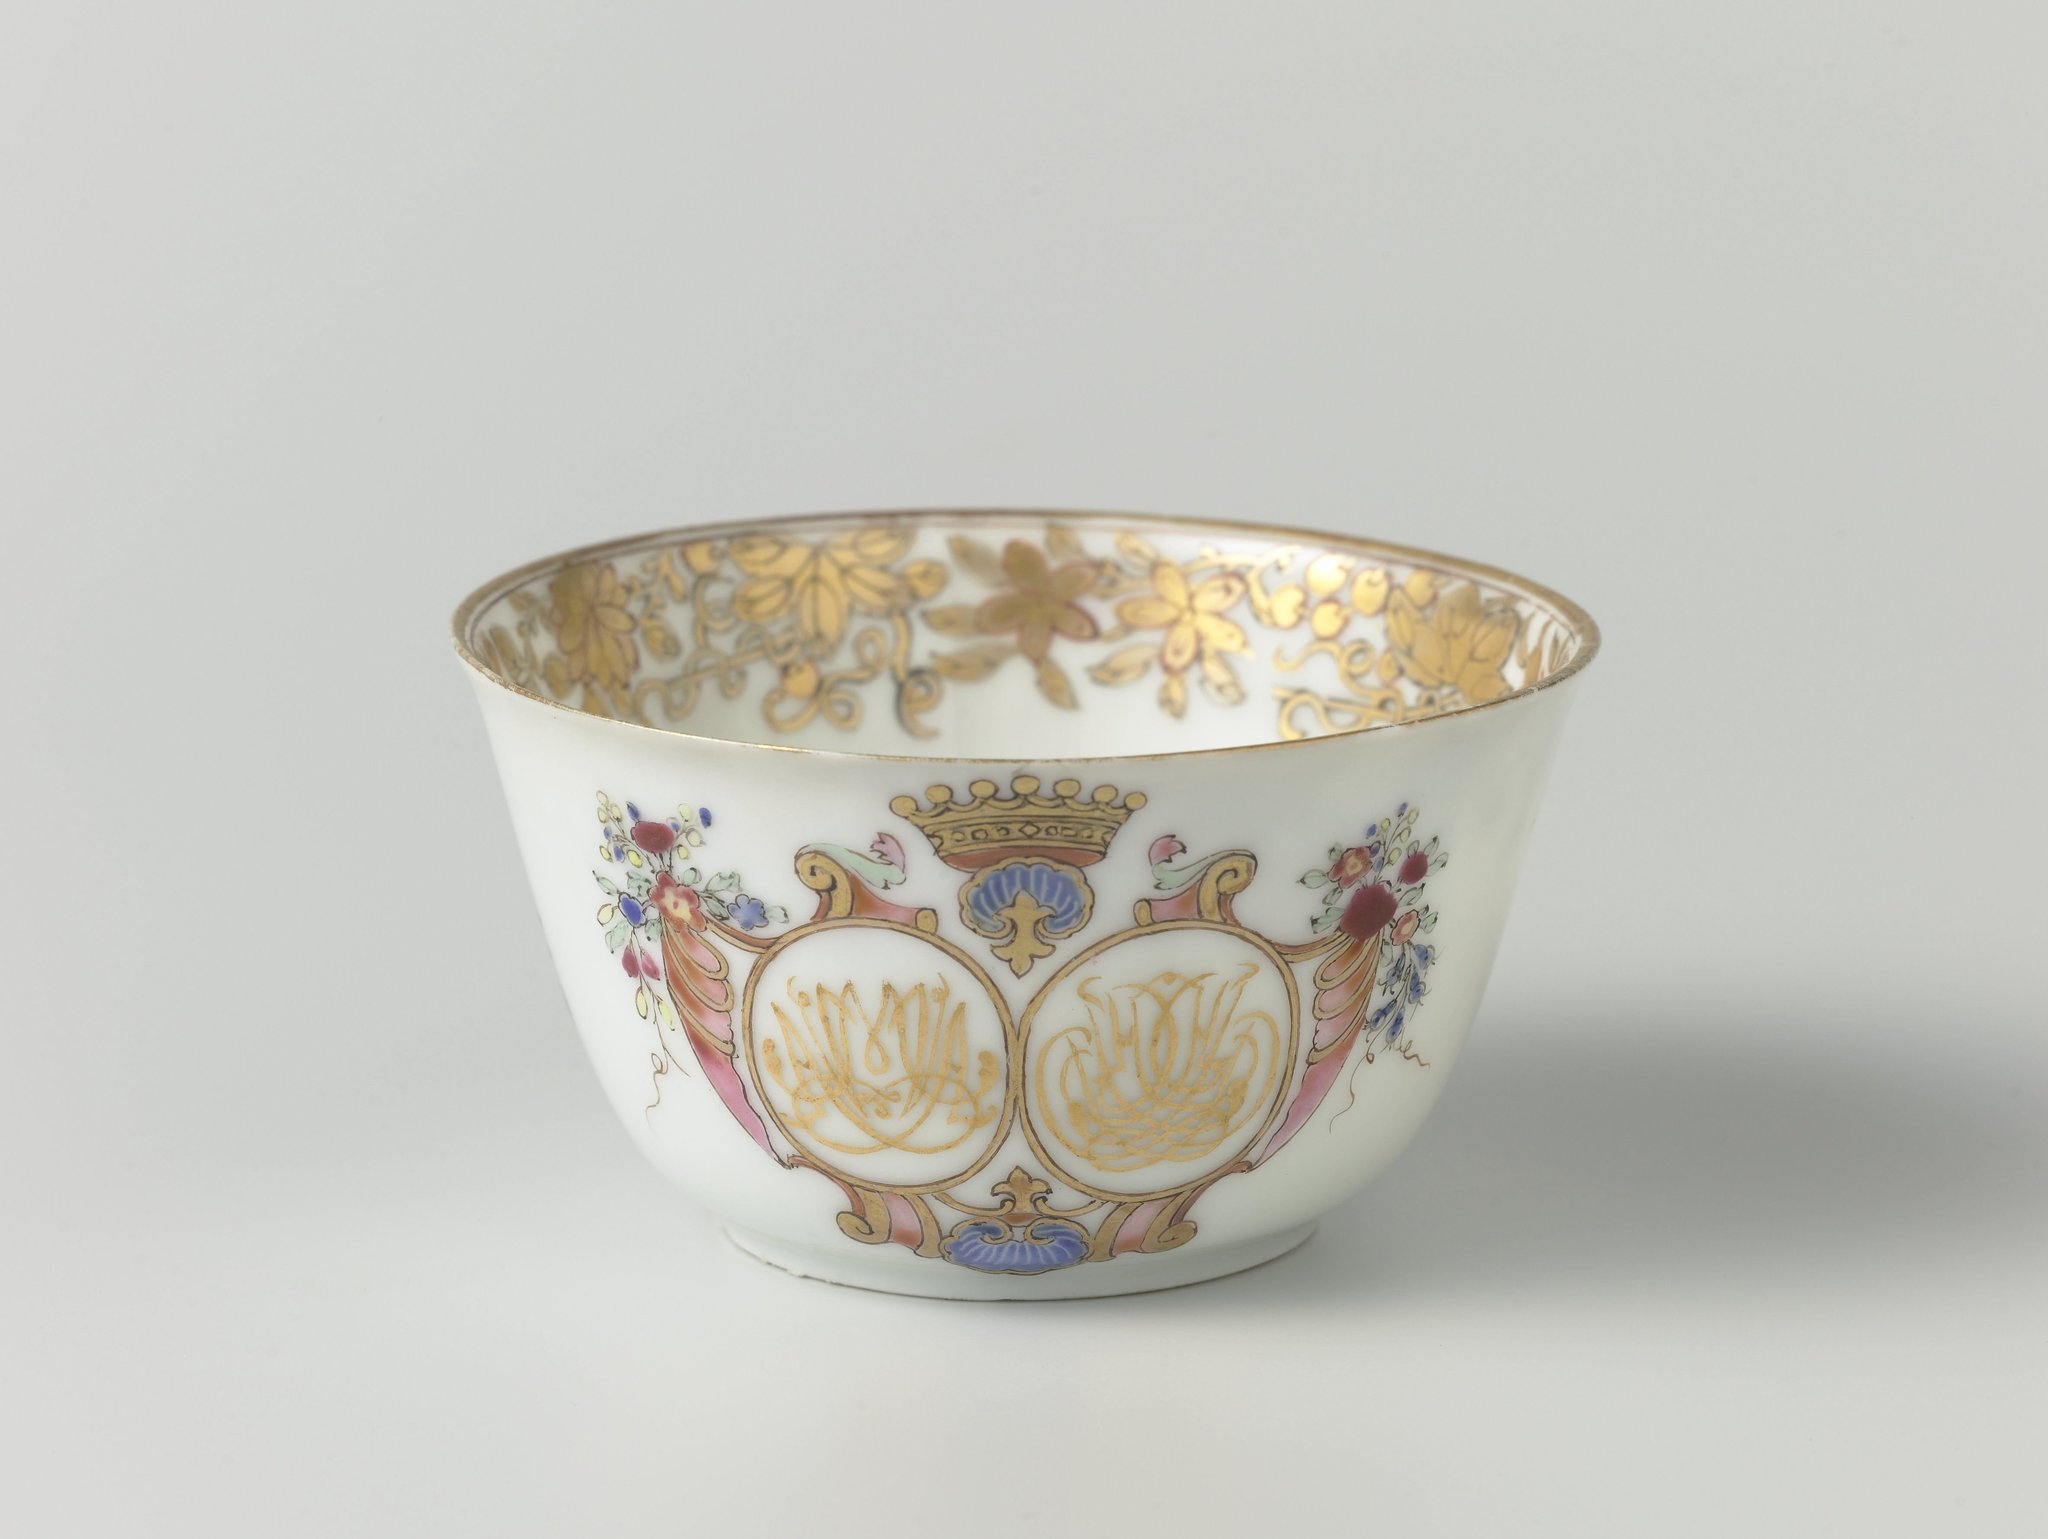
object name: tea cup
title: Bell-shaped cup from the 'Swellengrebel service' with a double crowned monogram and a border with floral scrolls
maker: Anonymous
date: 1740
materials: glaze, gold, paint, porcelain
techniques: firing, gilding, turning, vitrification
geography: china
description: De monogrammen 'MVA' en 'CHTD' staan voor Maurits van Aerden (1694-1746) en Constantia Helena ten Damme (1694-1772), getrouwd in 1716. Het servies is waarschijnlijk besteld ter ere van hun vijfentwingtigjarig huwelijksjubileum in 1741. (Campen, Jan van & Hartkamp-Jonxis, Ebeltje, Aziatische weelde : VOC-kunst in het Rijksmuseum, Zutphen 2011, p. 78)